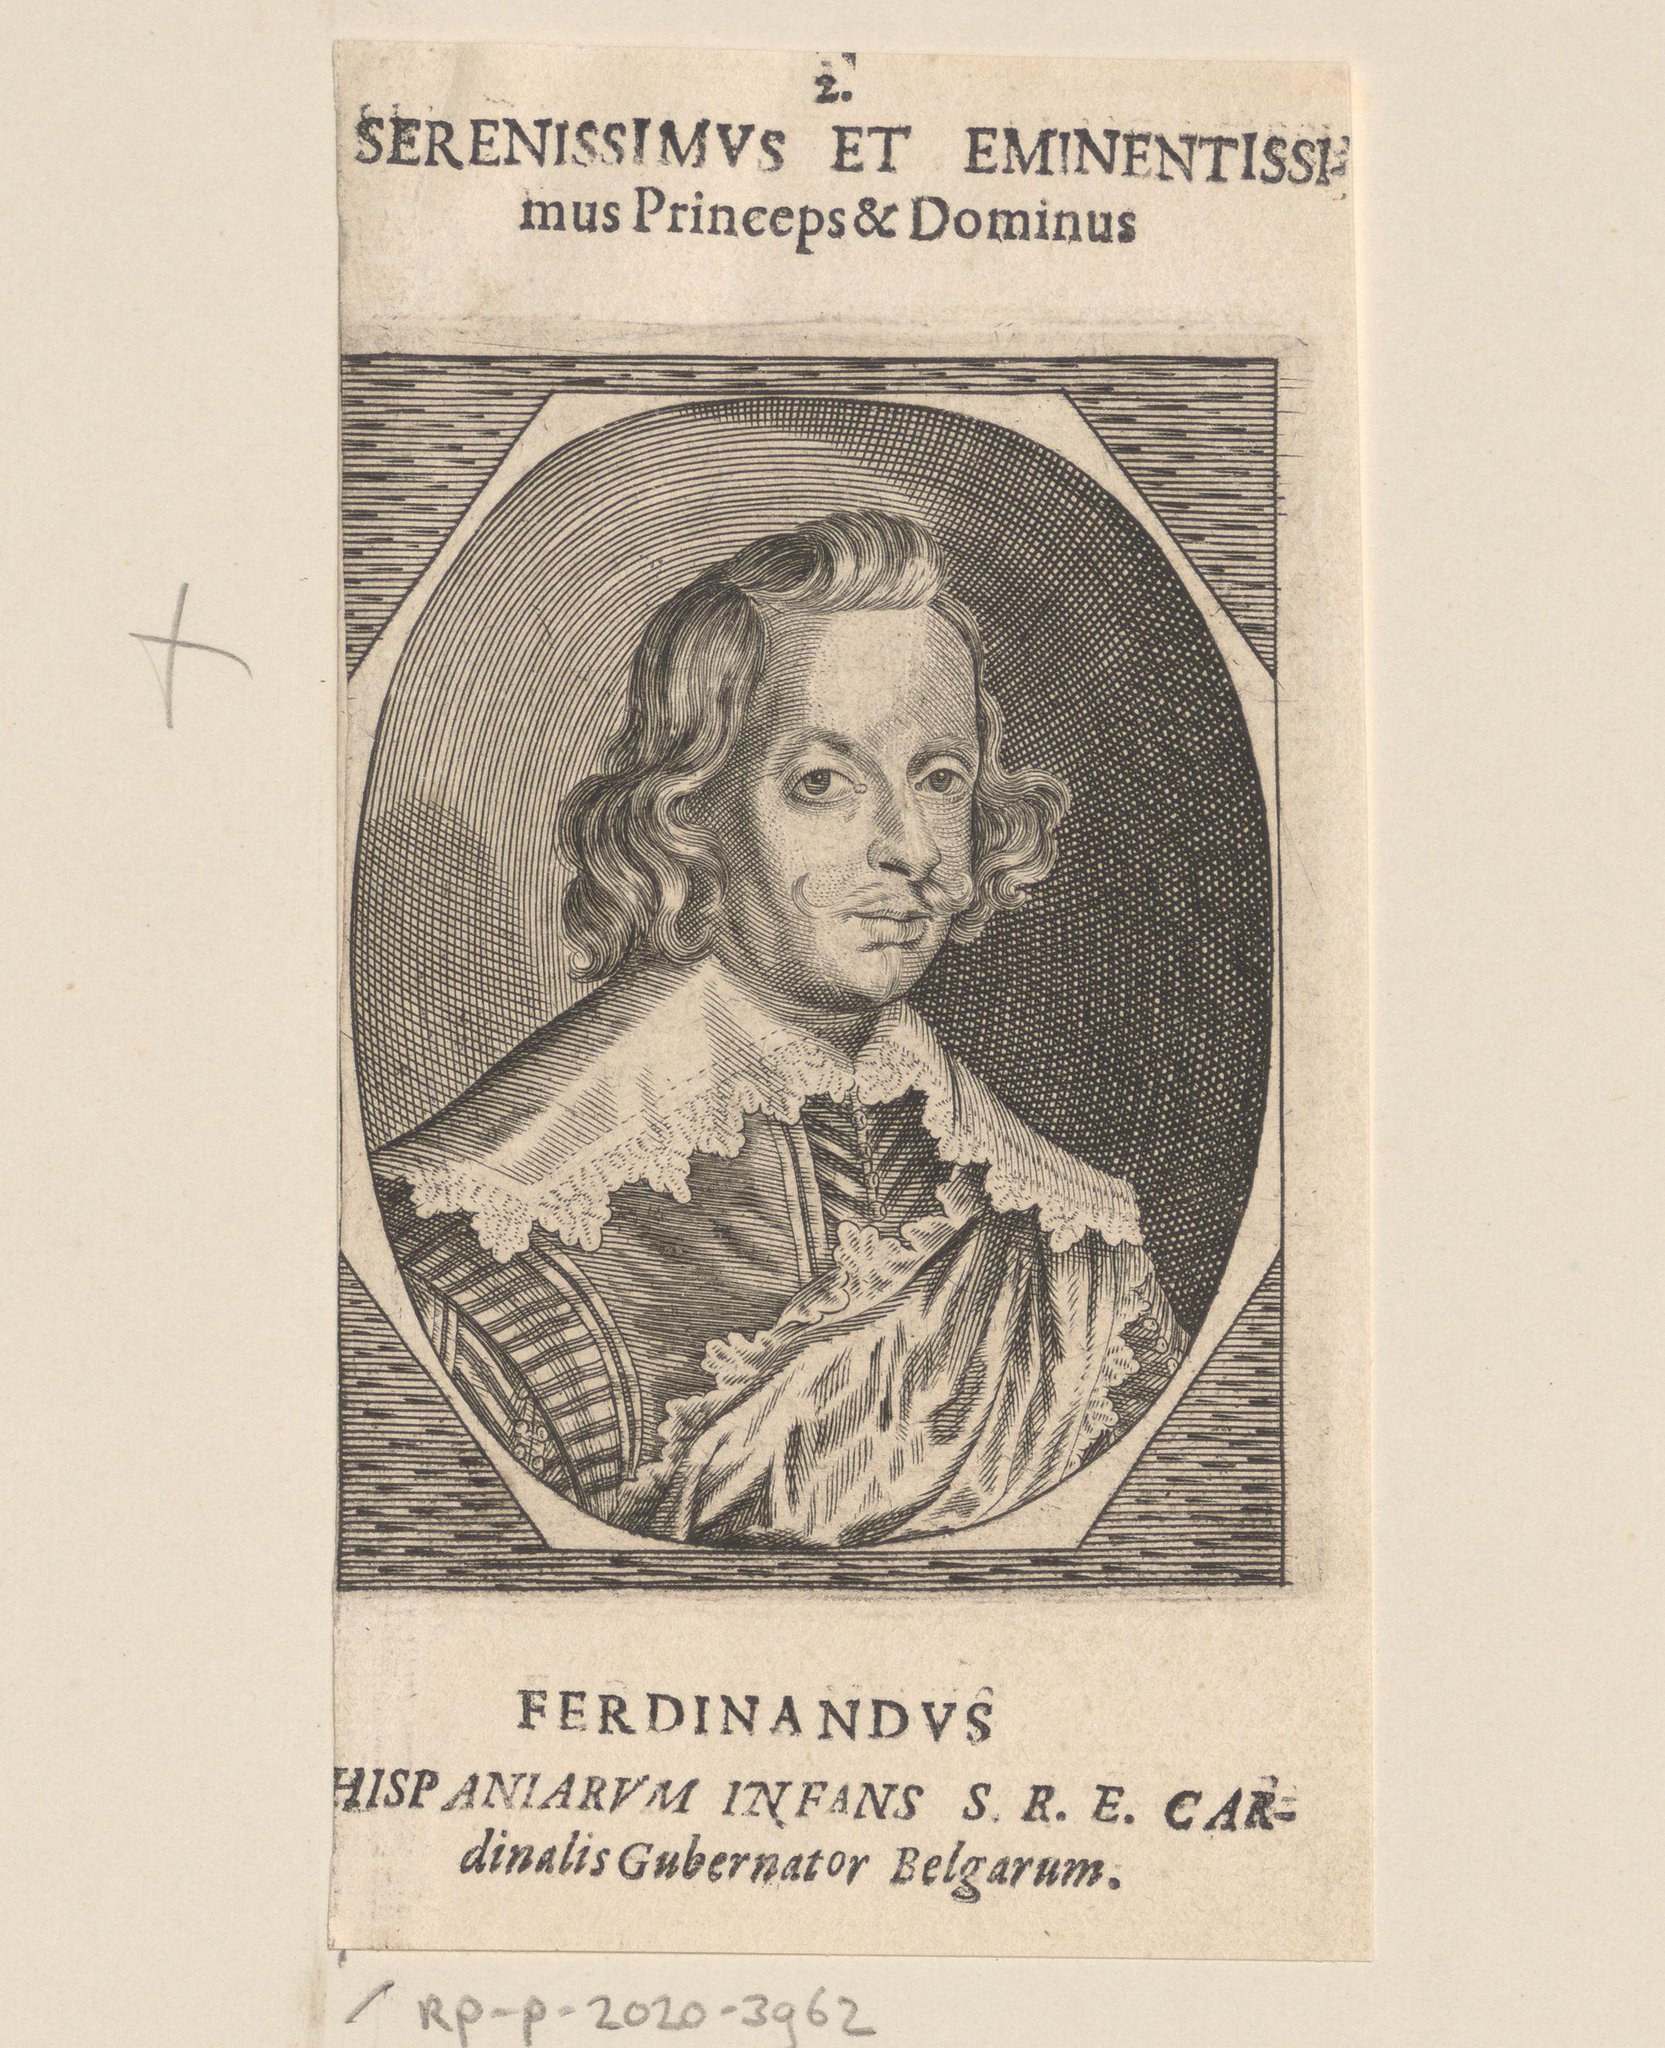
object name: print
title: Portret van Ferdinand van Oostenrijk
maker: Anonymous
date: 1676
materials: paper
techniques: engraving, letterpress printing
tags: landvoogd der zuidelijke nederlanden ferdinand van oostenrijk, historical persons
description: Prent met ander nummer gebruikt in: Brachelius, Adolphus. Historia Universalis Rerum Notabilium, Ubique Pene Terrarum Gestarum. Keulen: Johann Anton Kinckius, 1676. Deze prent is vermoedelijk in een eerdere of latere publicatie gebruikt.